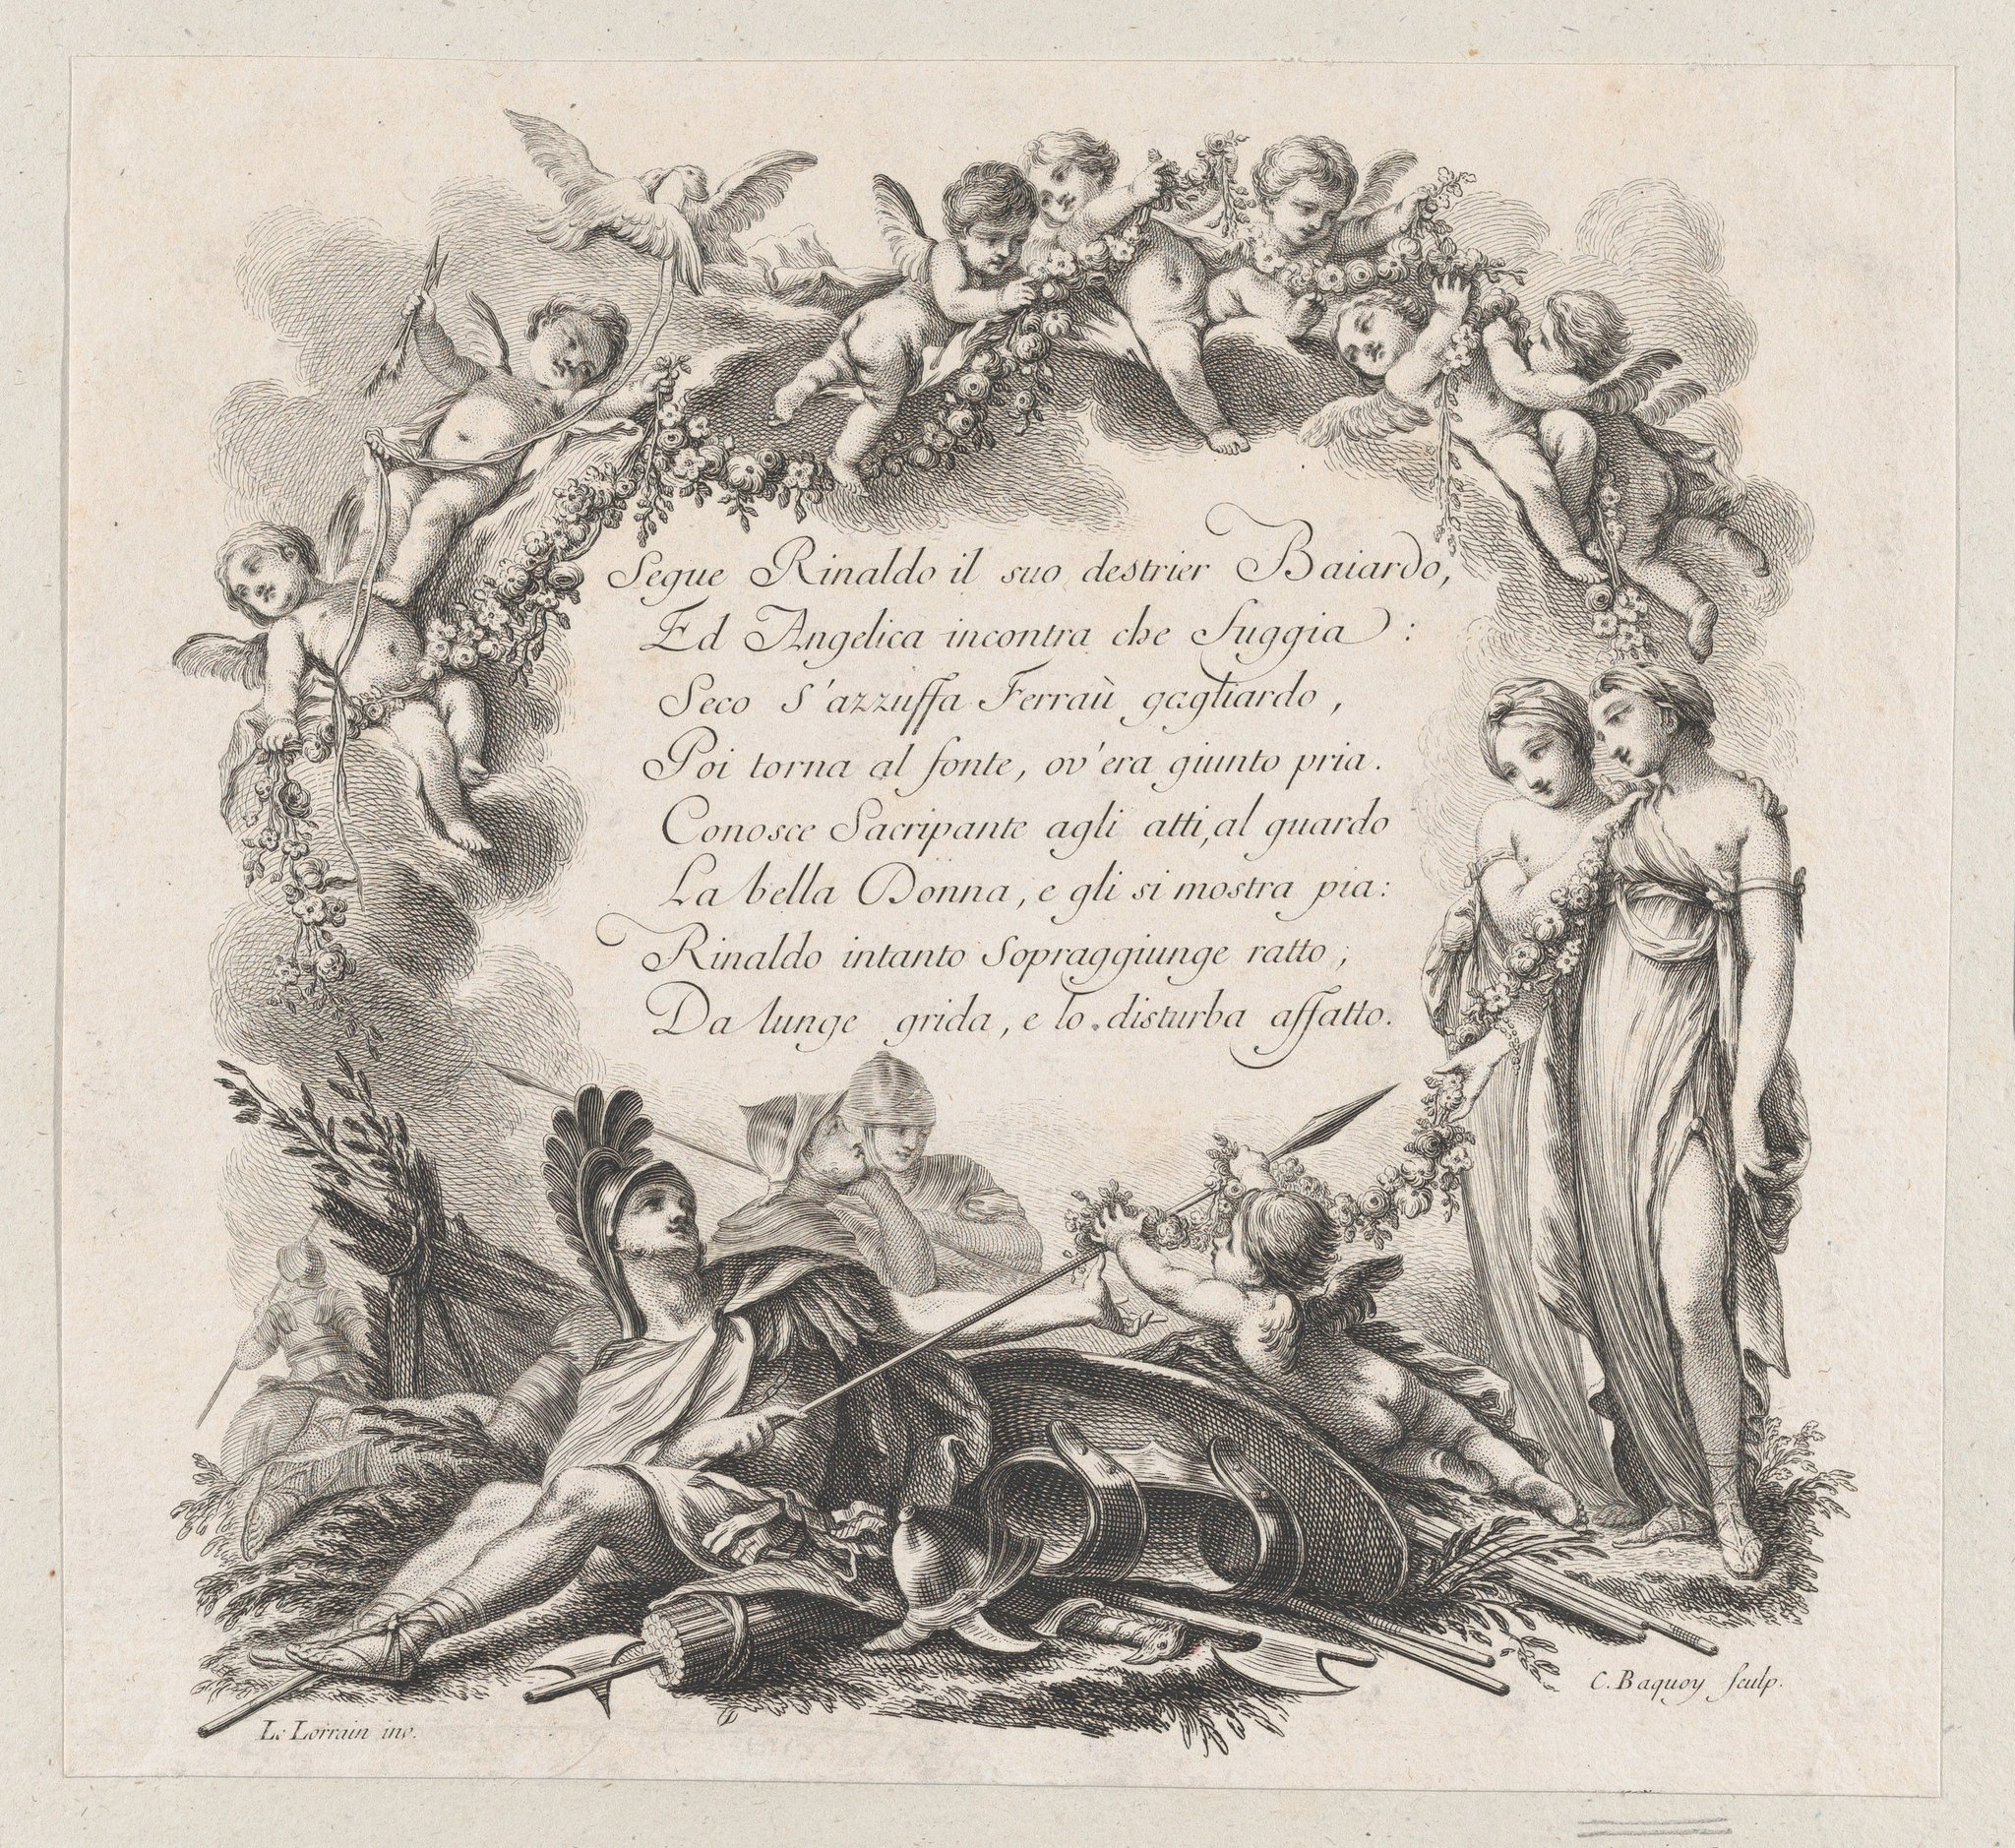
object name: print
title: Vignette for the first chant of Roland Furieux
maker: c. baquoy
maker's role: artist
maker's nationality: french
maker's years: 18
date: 1701-1800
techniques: engraving, etching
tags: birds,men,women